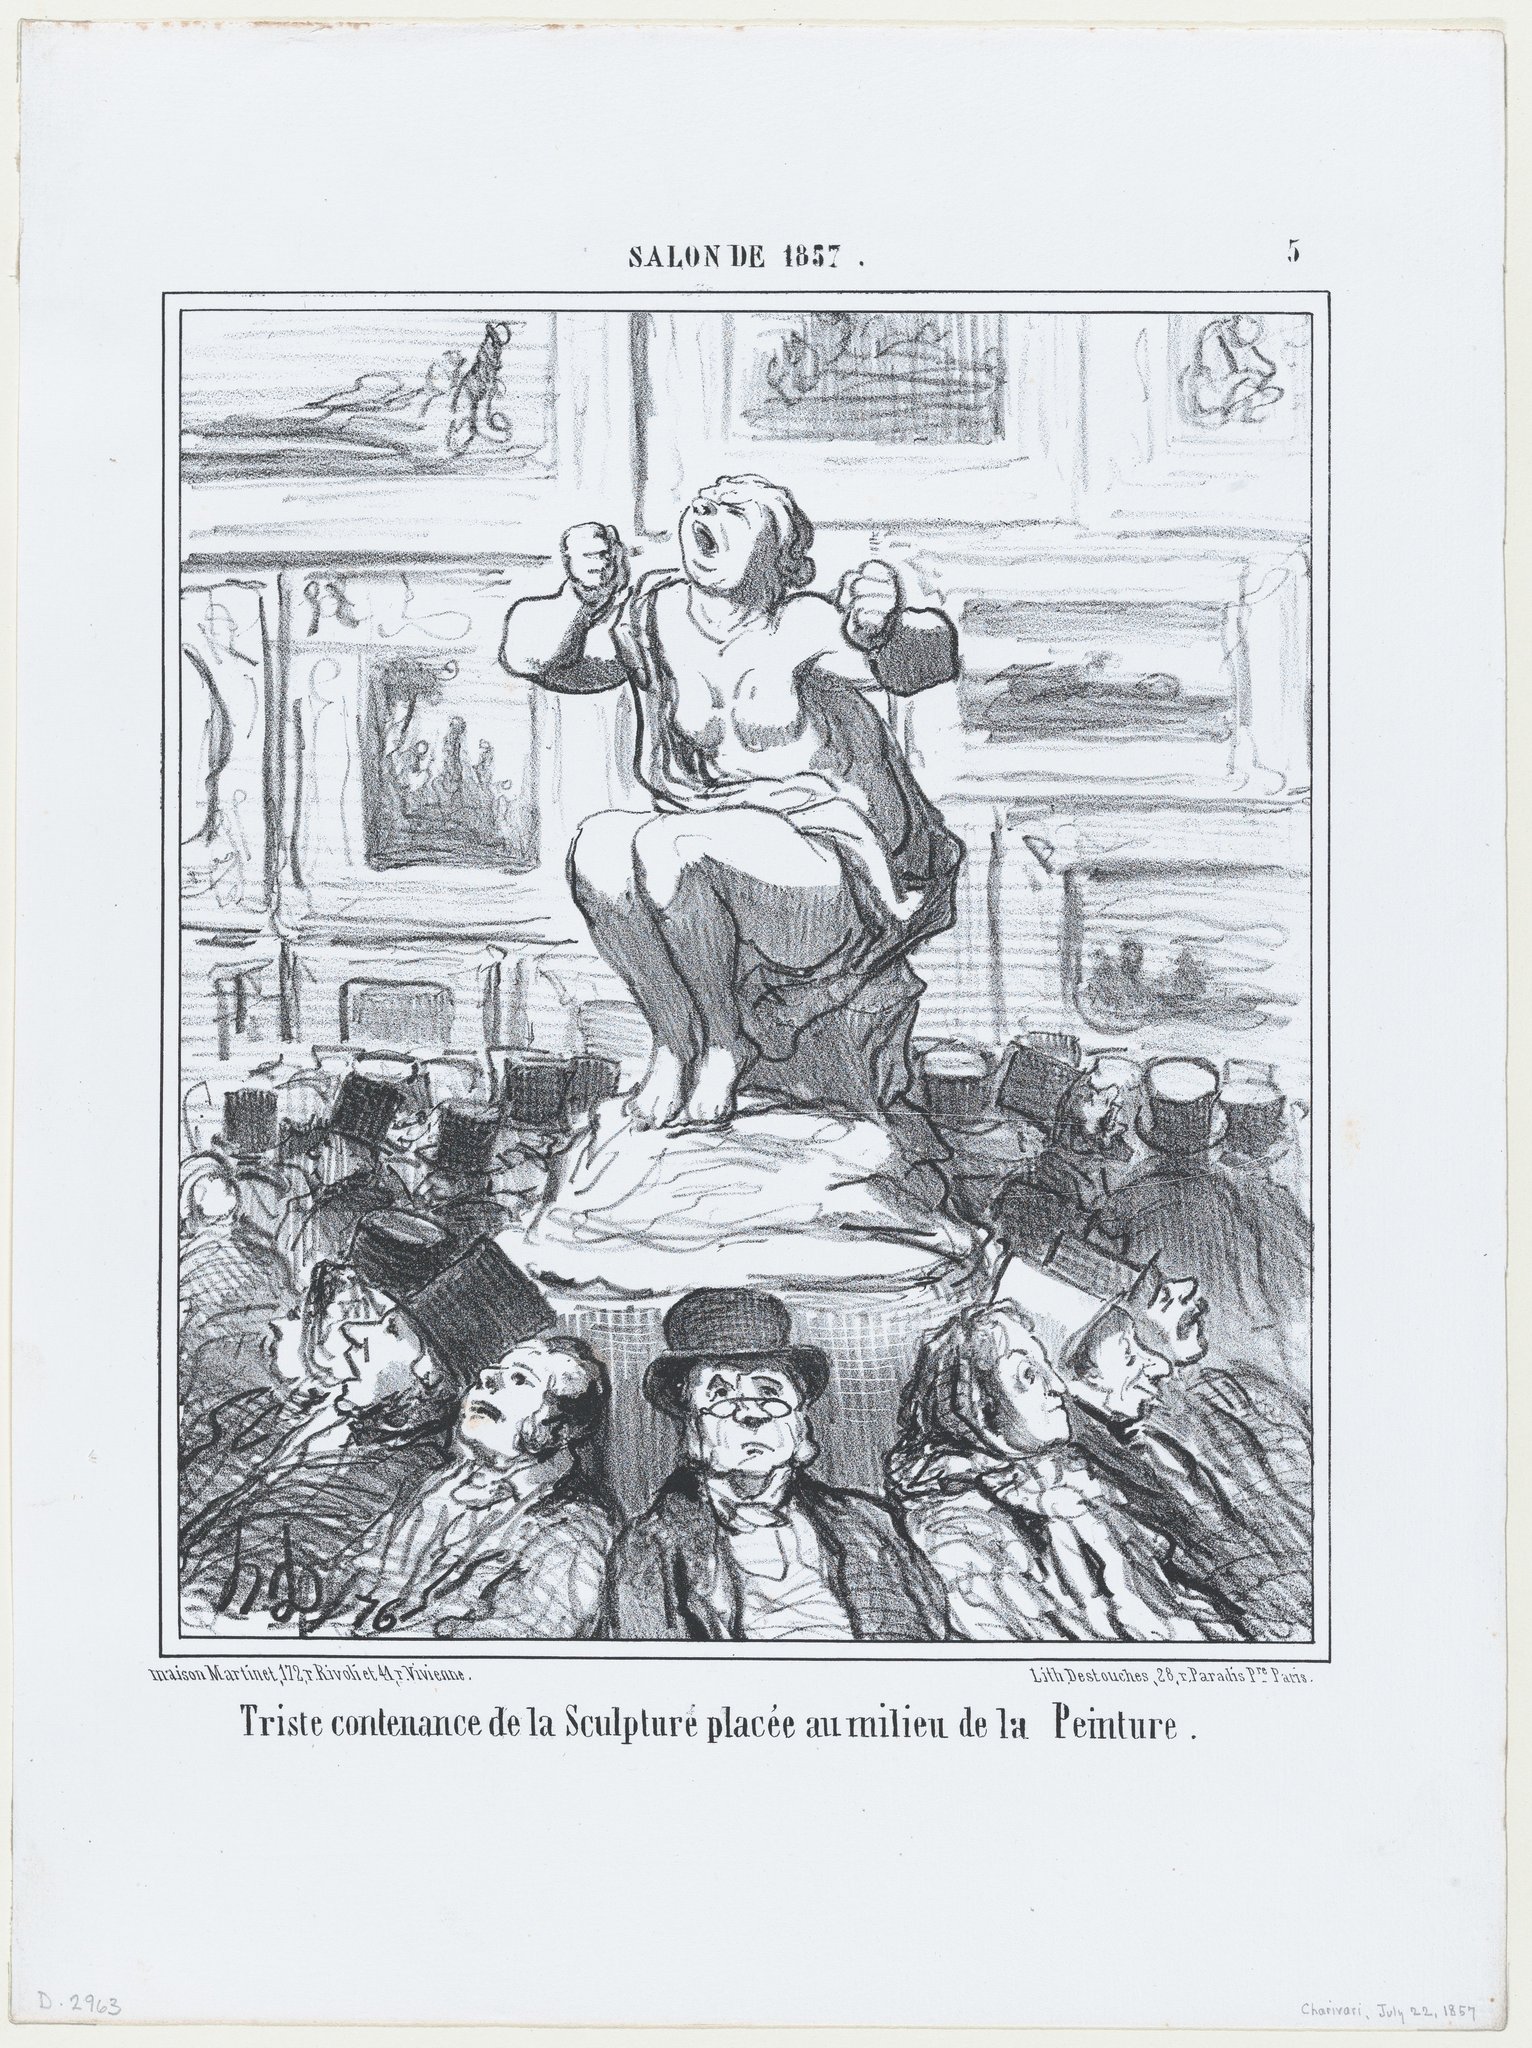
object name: print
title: Triste contenance de la Sculpture placée au milieu de la Peinture, from Le Salon de 1857, published in "Le Charivari"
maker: honoré daumier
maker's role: artist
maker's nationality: french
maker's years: 1808-1879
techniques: lithograph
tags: sculpture,men,female nudes